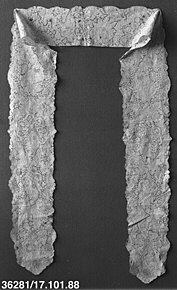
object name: cap border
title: Cap trimming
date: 1701-1733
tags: flowers,leaves